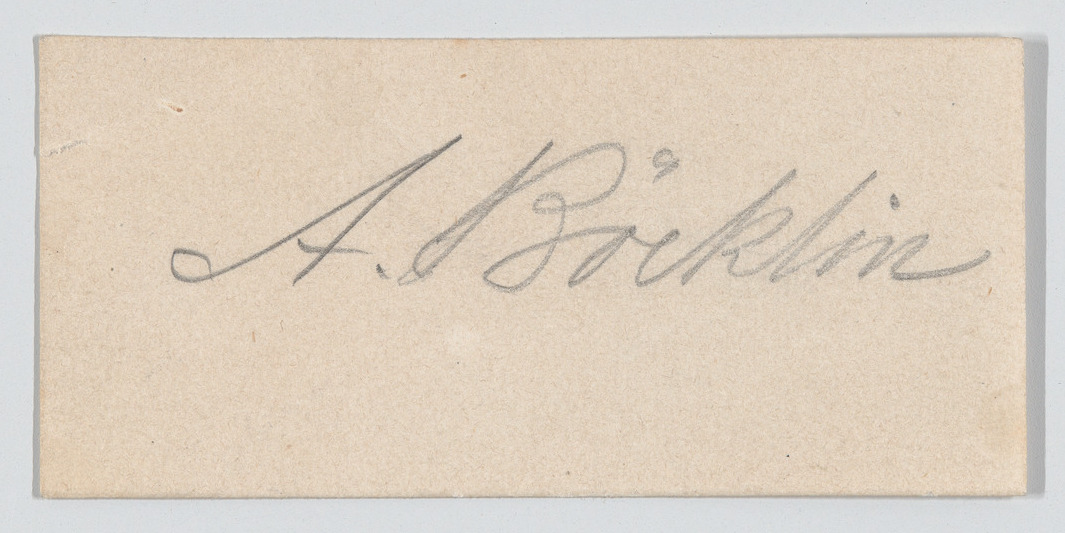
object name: print, calling card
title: Arnold Böcklin, calling card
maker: arnold böcklin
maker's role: artist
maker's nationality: swiss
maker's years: 1827-1901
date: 1845-1901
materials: graphite